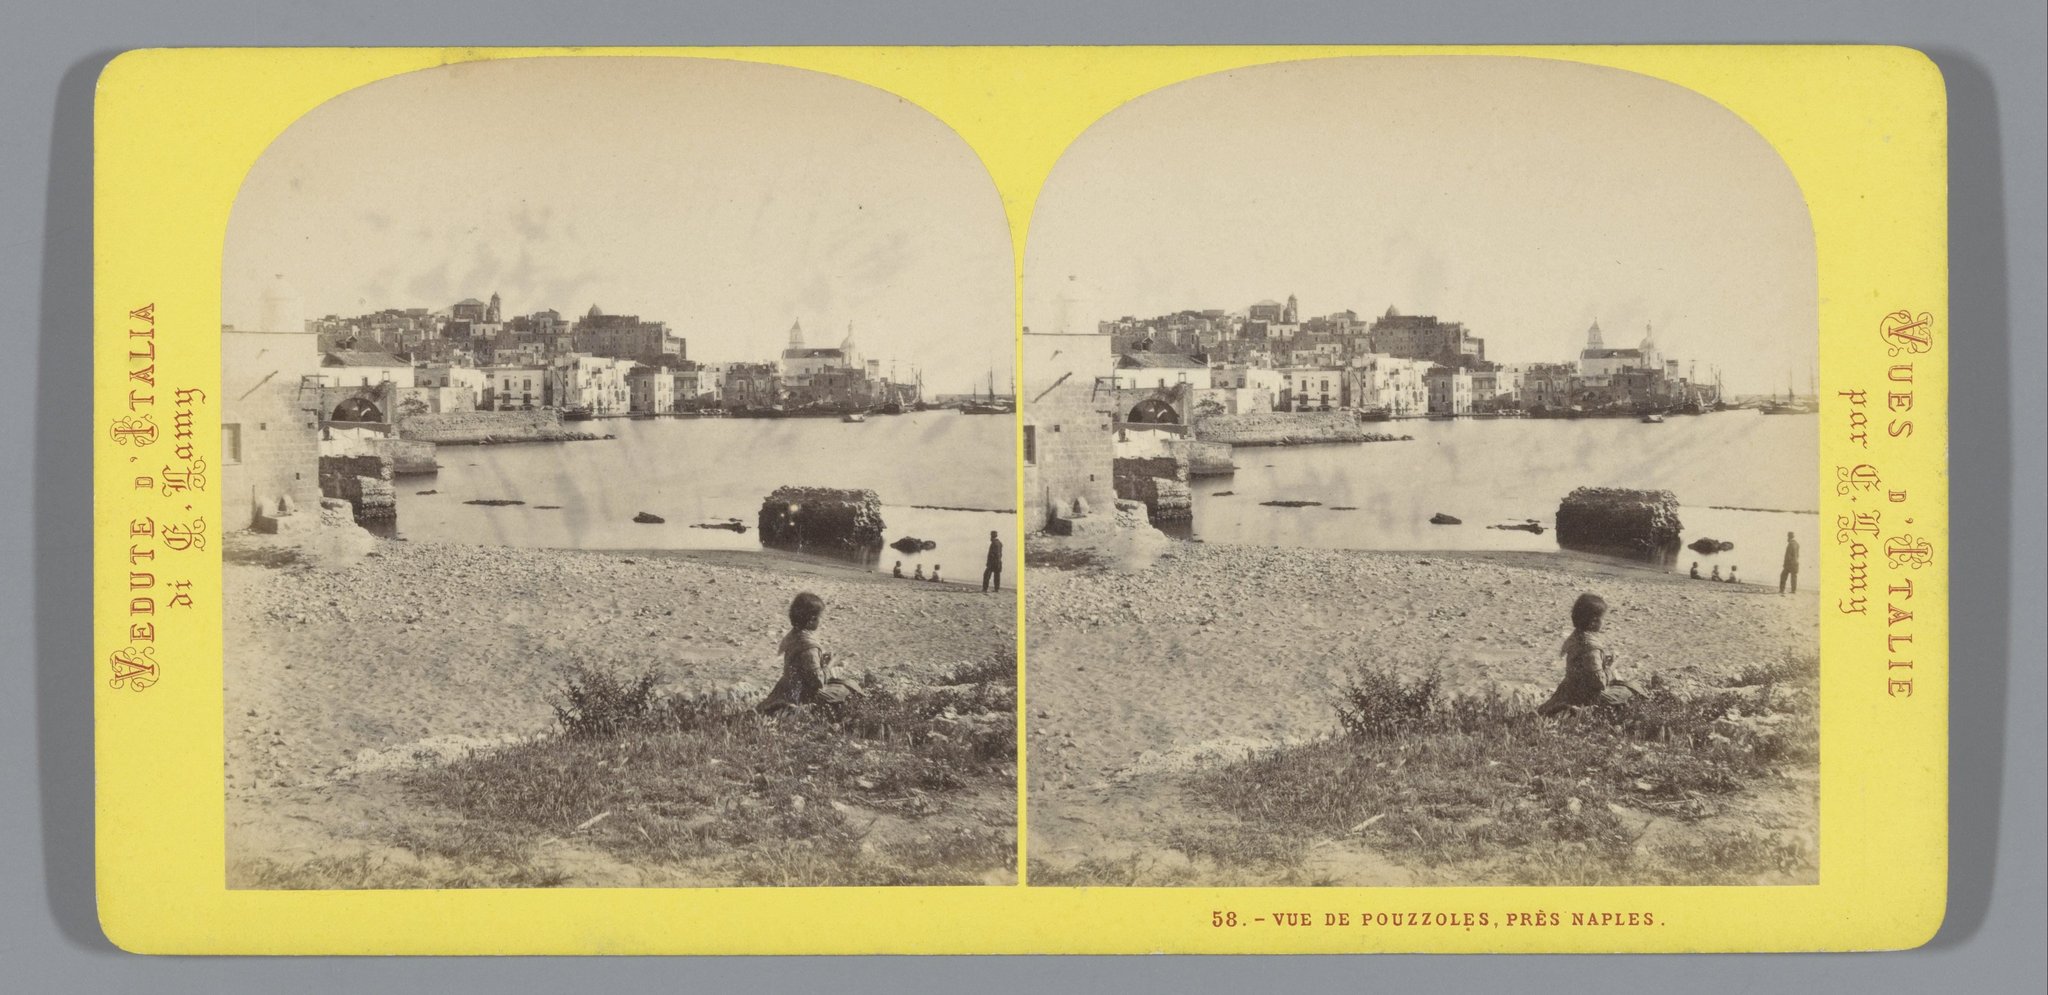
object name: stereograph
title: Vue de Pouzzoles, près Naples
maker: ernest eléonor pierre lamy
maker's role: publisher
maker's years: 1828-1900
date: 1861-1878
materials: cardboard, paper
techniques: albumen print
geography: pozzuoli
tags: gulf, bay, beach, prospect of city, town panorama, silhouette of city, pozzuoli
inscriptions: number: ‘58.’